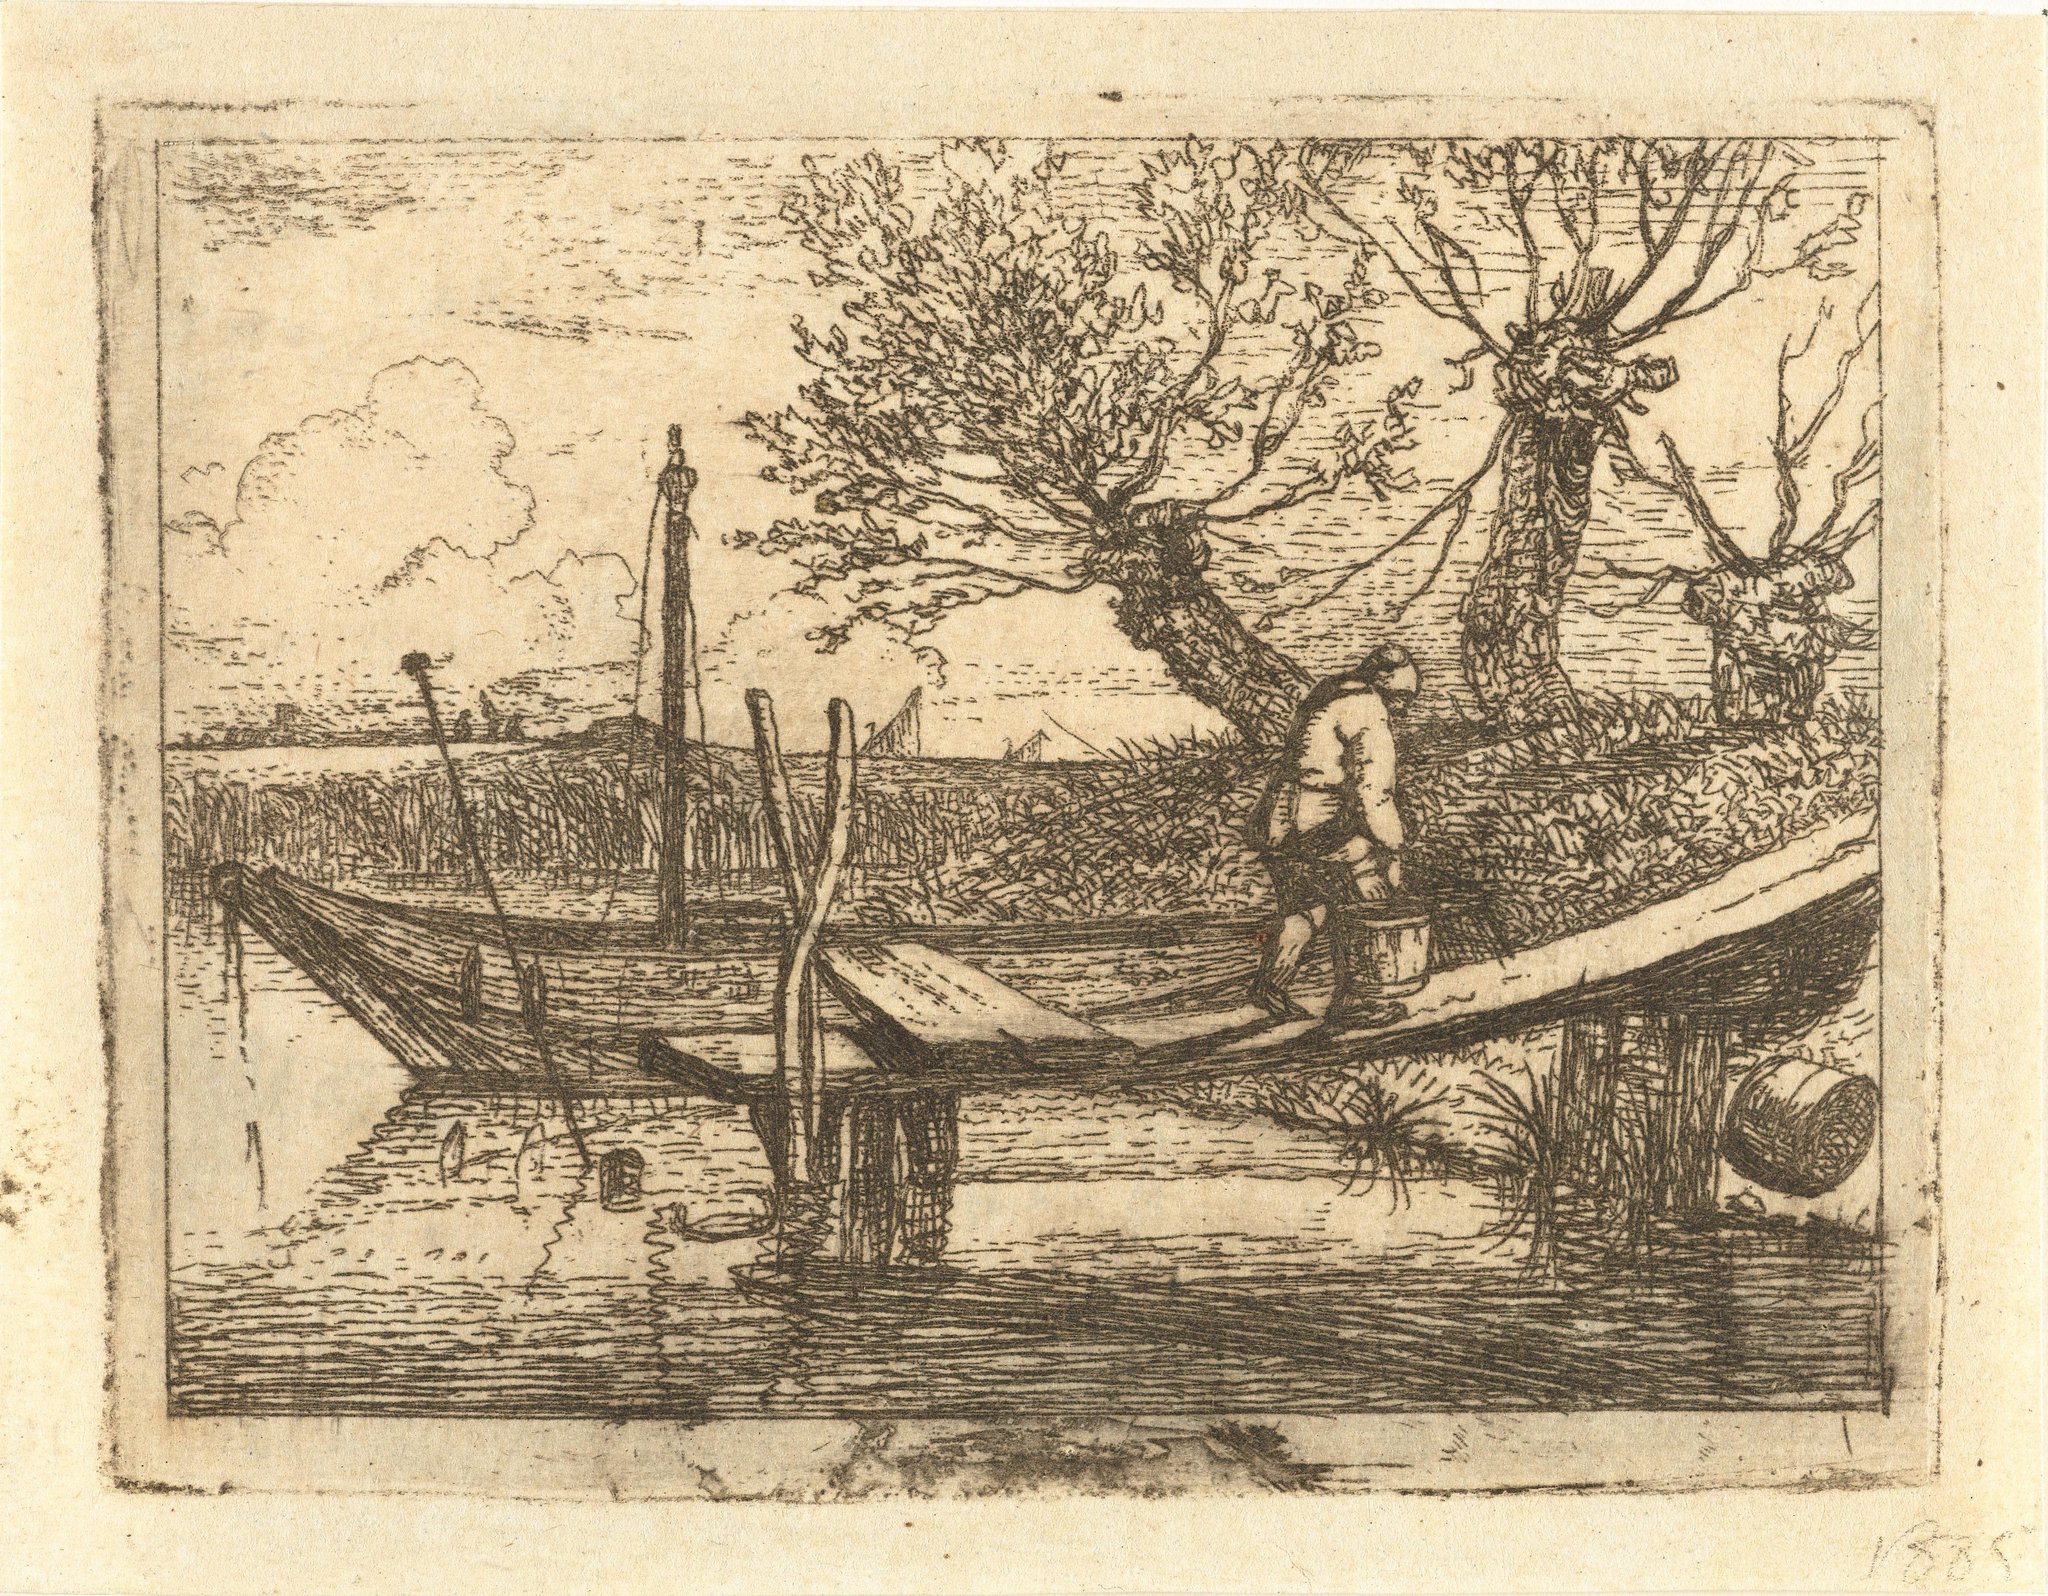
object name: print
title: Landschap met kleine aanlegsteiger waarop een lopende man met emmer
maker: albertus brondgeest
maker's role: draughtsman, print maker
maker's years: 1786-1849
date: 1796-1849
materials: paper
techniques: etching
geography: netherlands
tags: water course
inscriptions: collector's mark: Lugt 2228